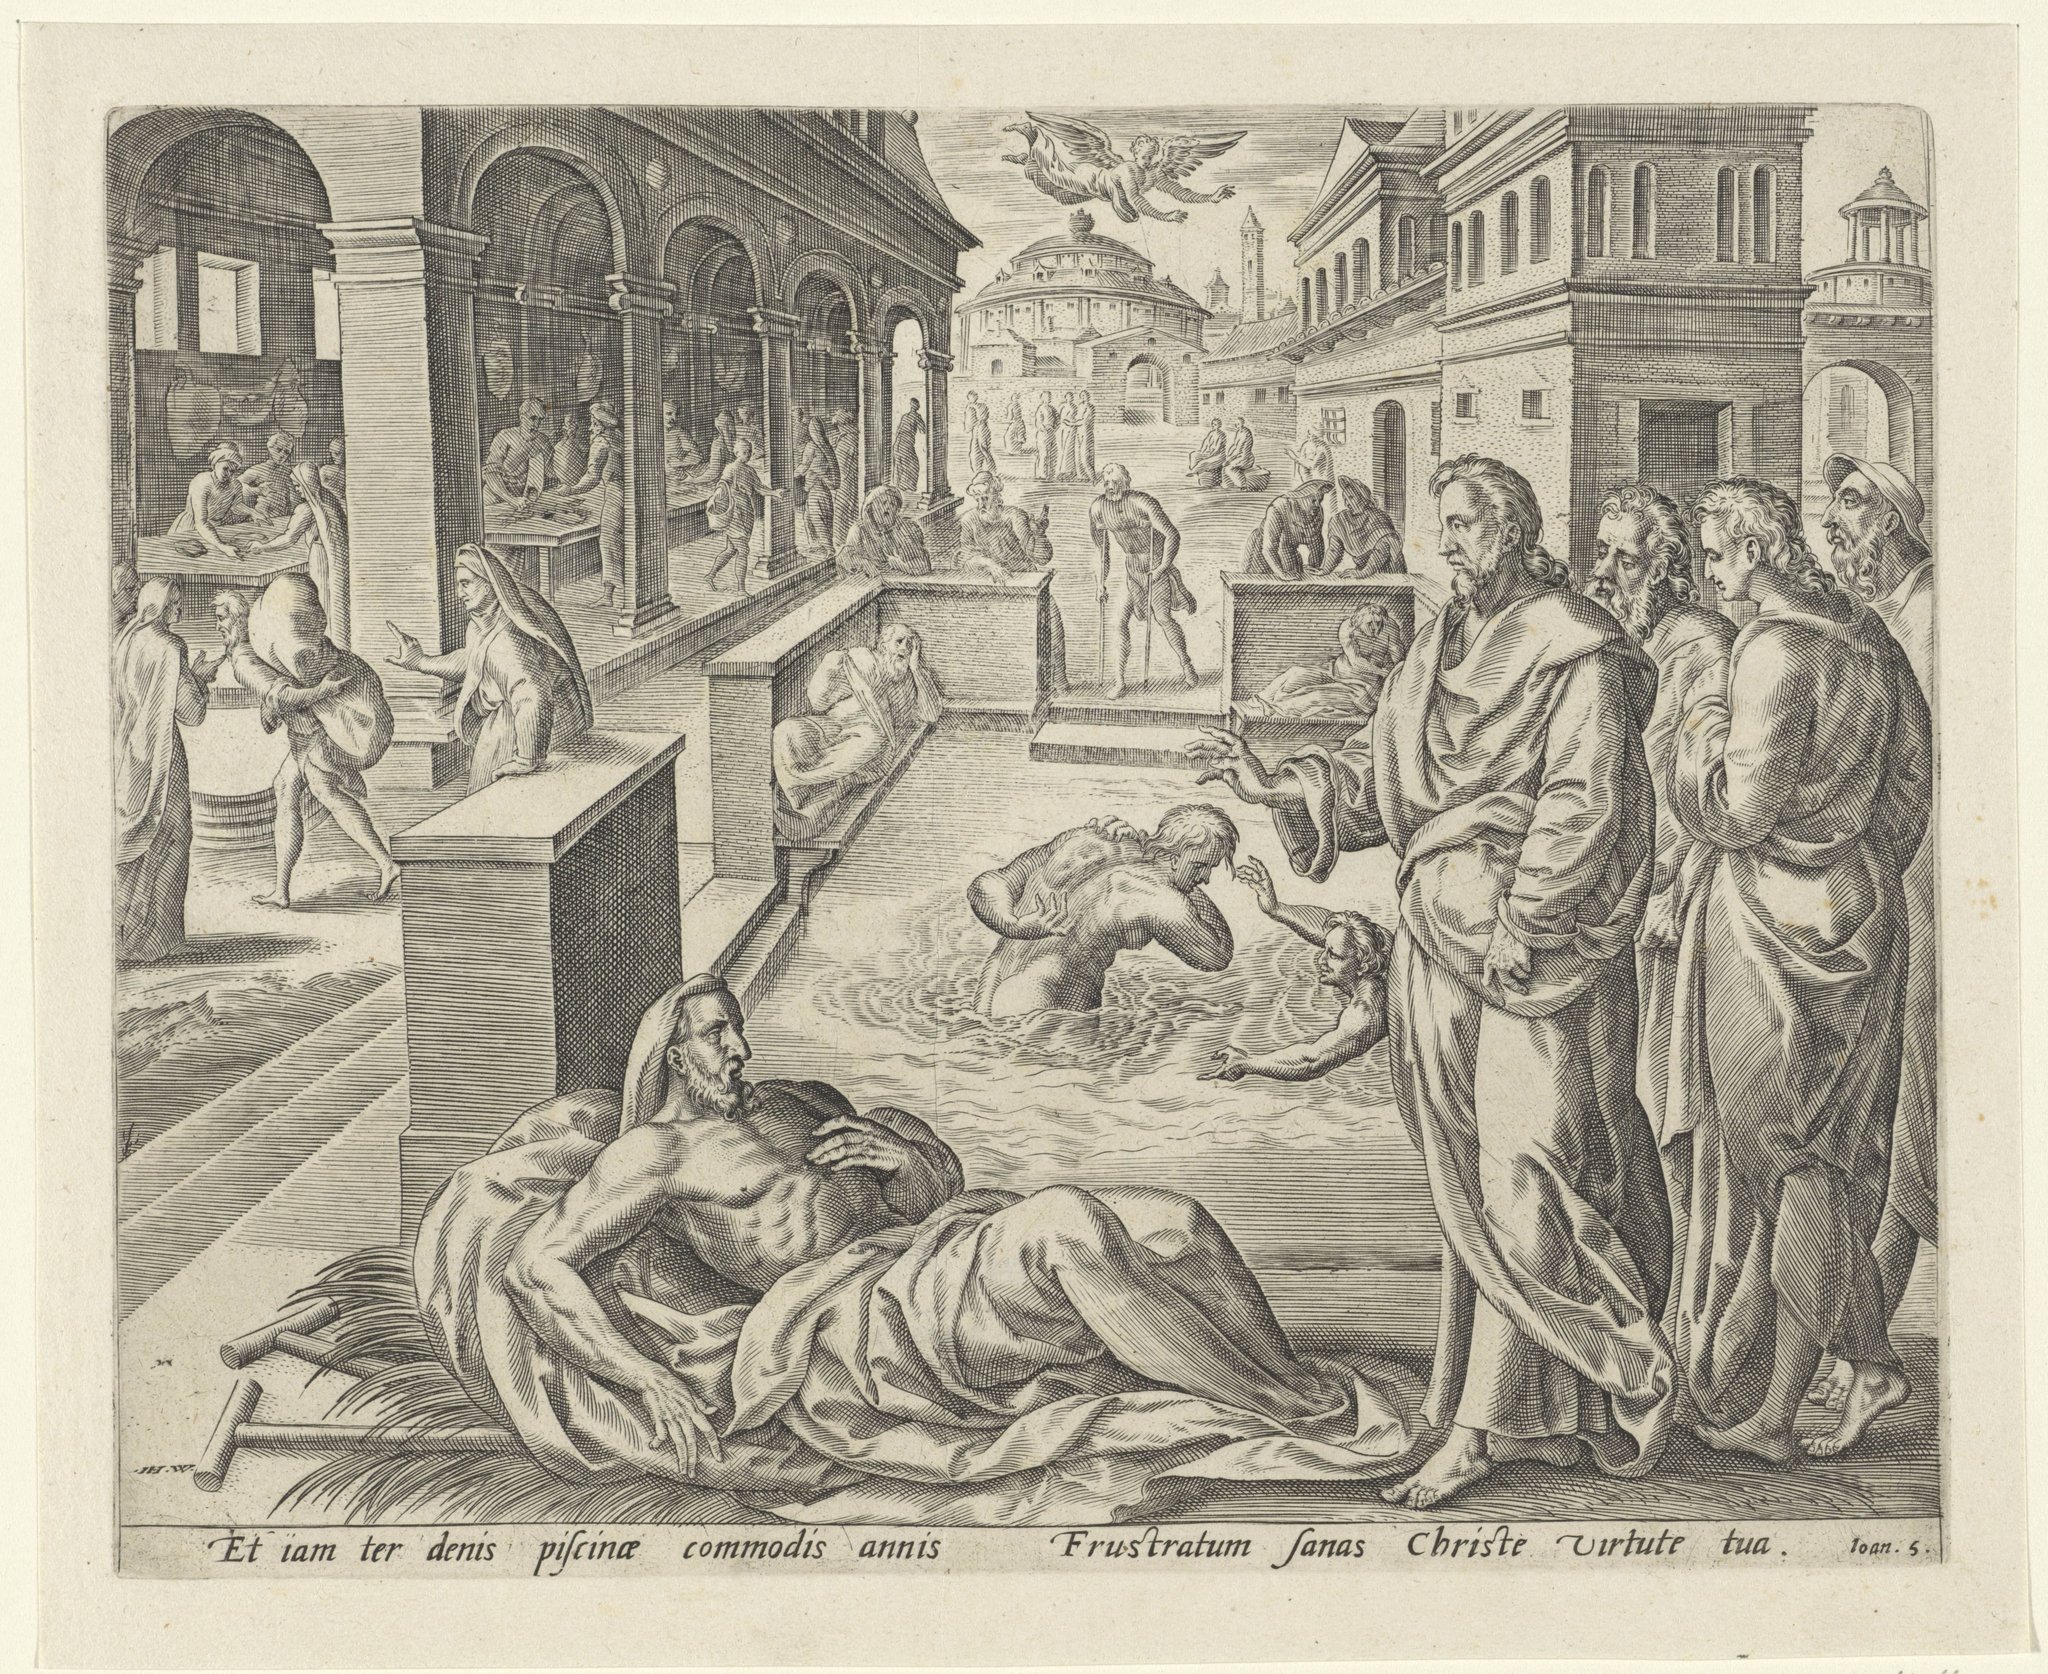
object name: print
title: Wonderen van Christus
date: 1585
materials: paper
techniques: engraving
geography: antwerp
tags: disabilities, deformations, christ says to a paralytic man: 'rise, take up your pallet (bed)', sick people lying near the pool of bethesda ~ christ healing paralytics (john 5:1-9)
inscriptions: collector's mark: Lugt 2228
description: Genezing op sabbat. Christus geneest een man die al achtendertig jaar ziek is bij het bad van Betesda (Betzata). Een man wordt ondergedompeld in het bad. Rond het water zitten zieke en blinde mensen en mensen met beperkingen. In de lucht vliegt een engel. Onder de voorstelling een verwijzing in het Latijn naar de Bijbeltekst in Joh. 5.